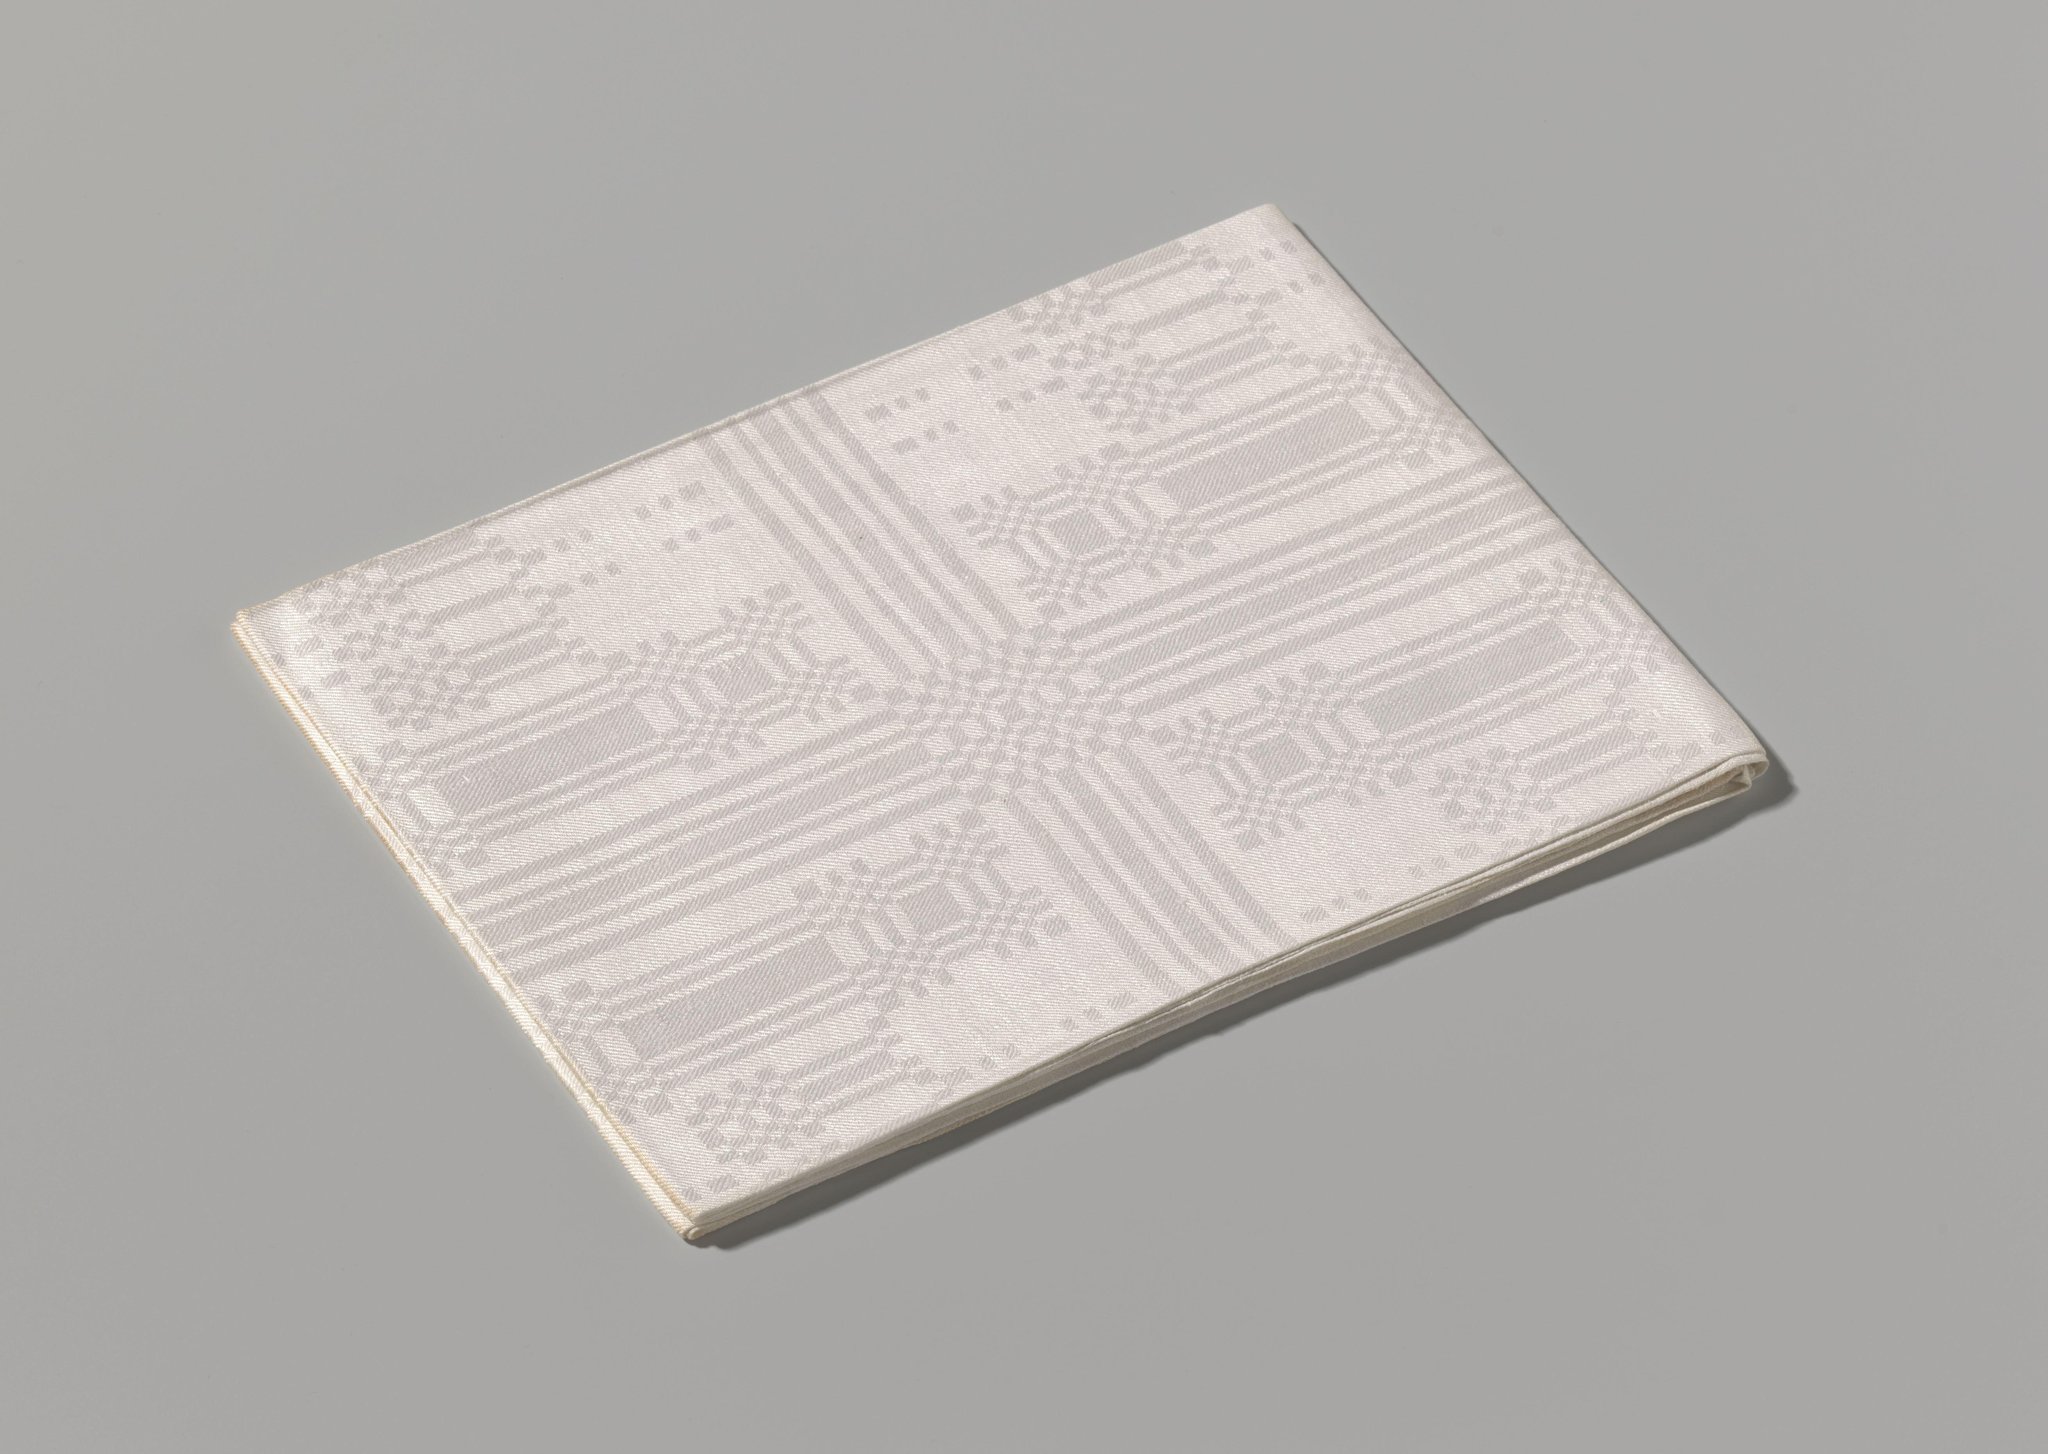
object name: napkin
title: Servet van linnen met pellenpatroon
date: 1740-1786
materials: linen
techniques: twill, peeled fabric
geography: northern netherlands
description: wit linnen servet met pellen patroon, merk kroon IAVG 36